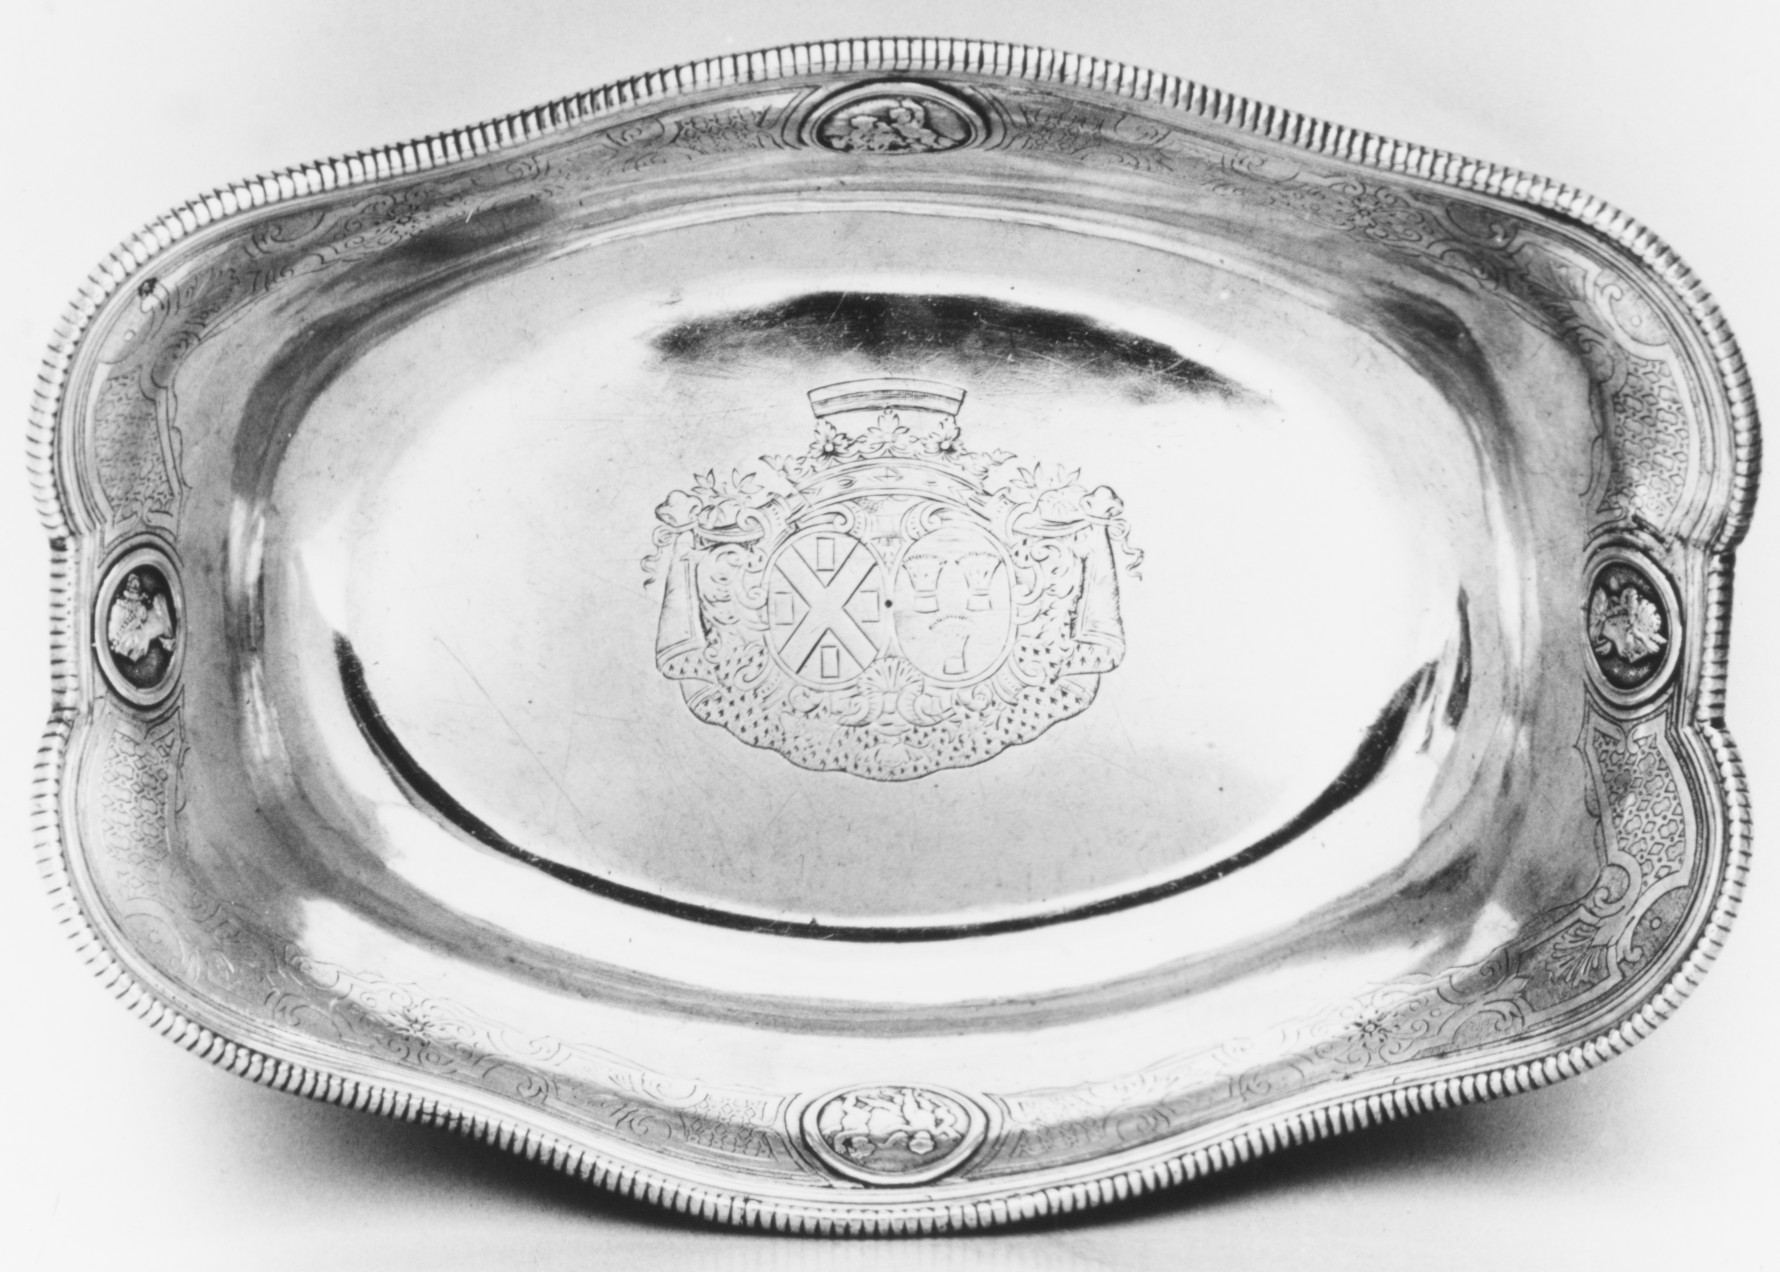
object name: basin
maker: léopold antoine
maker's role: maker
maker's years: 1676-1759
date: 1727-1729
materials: silver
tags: coat of arms